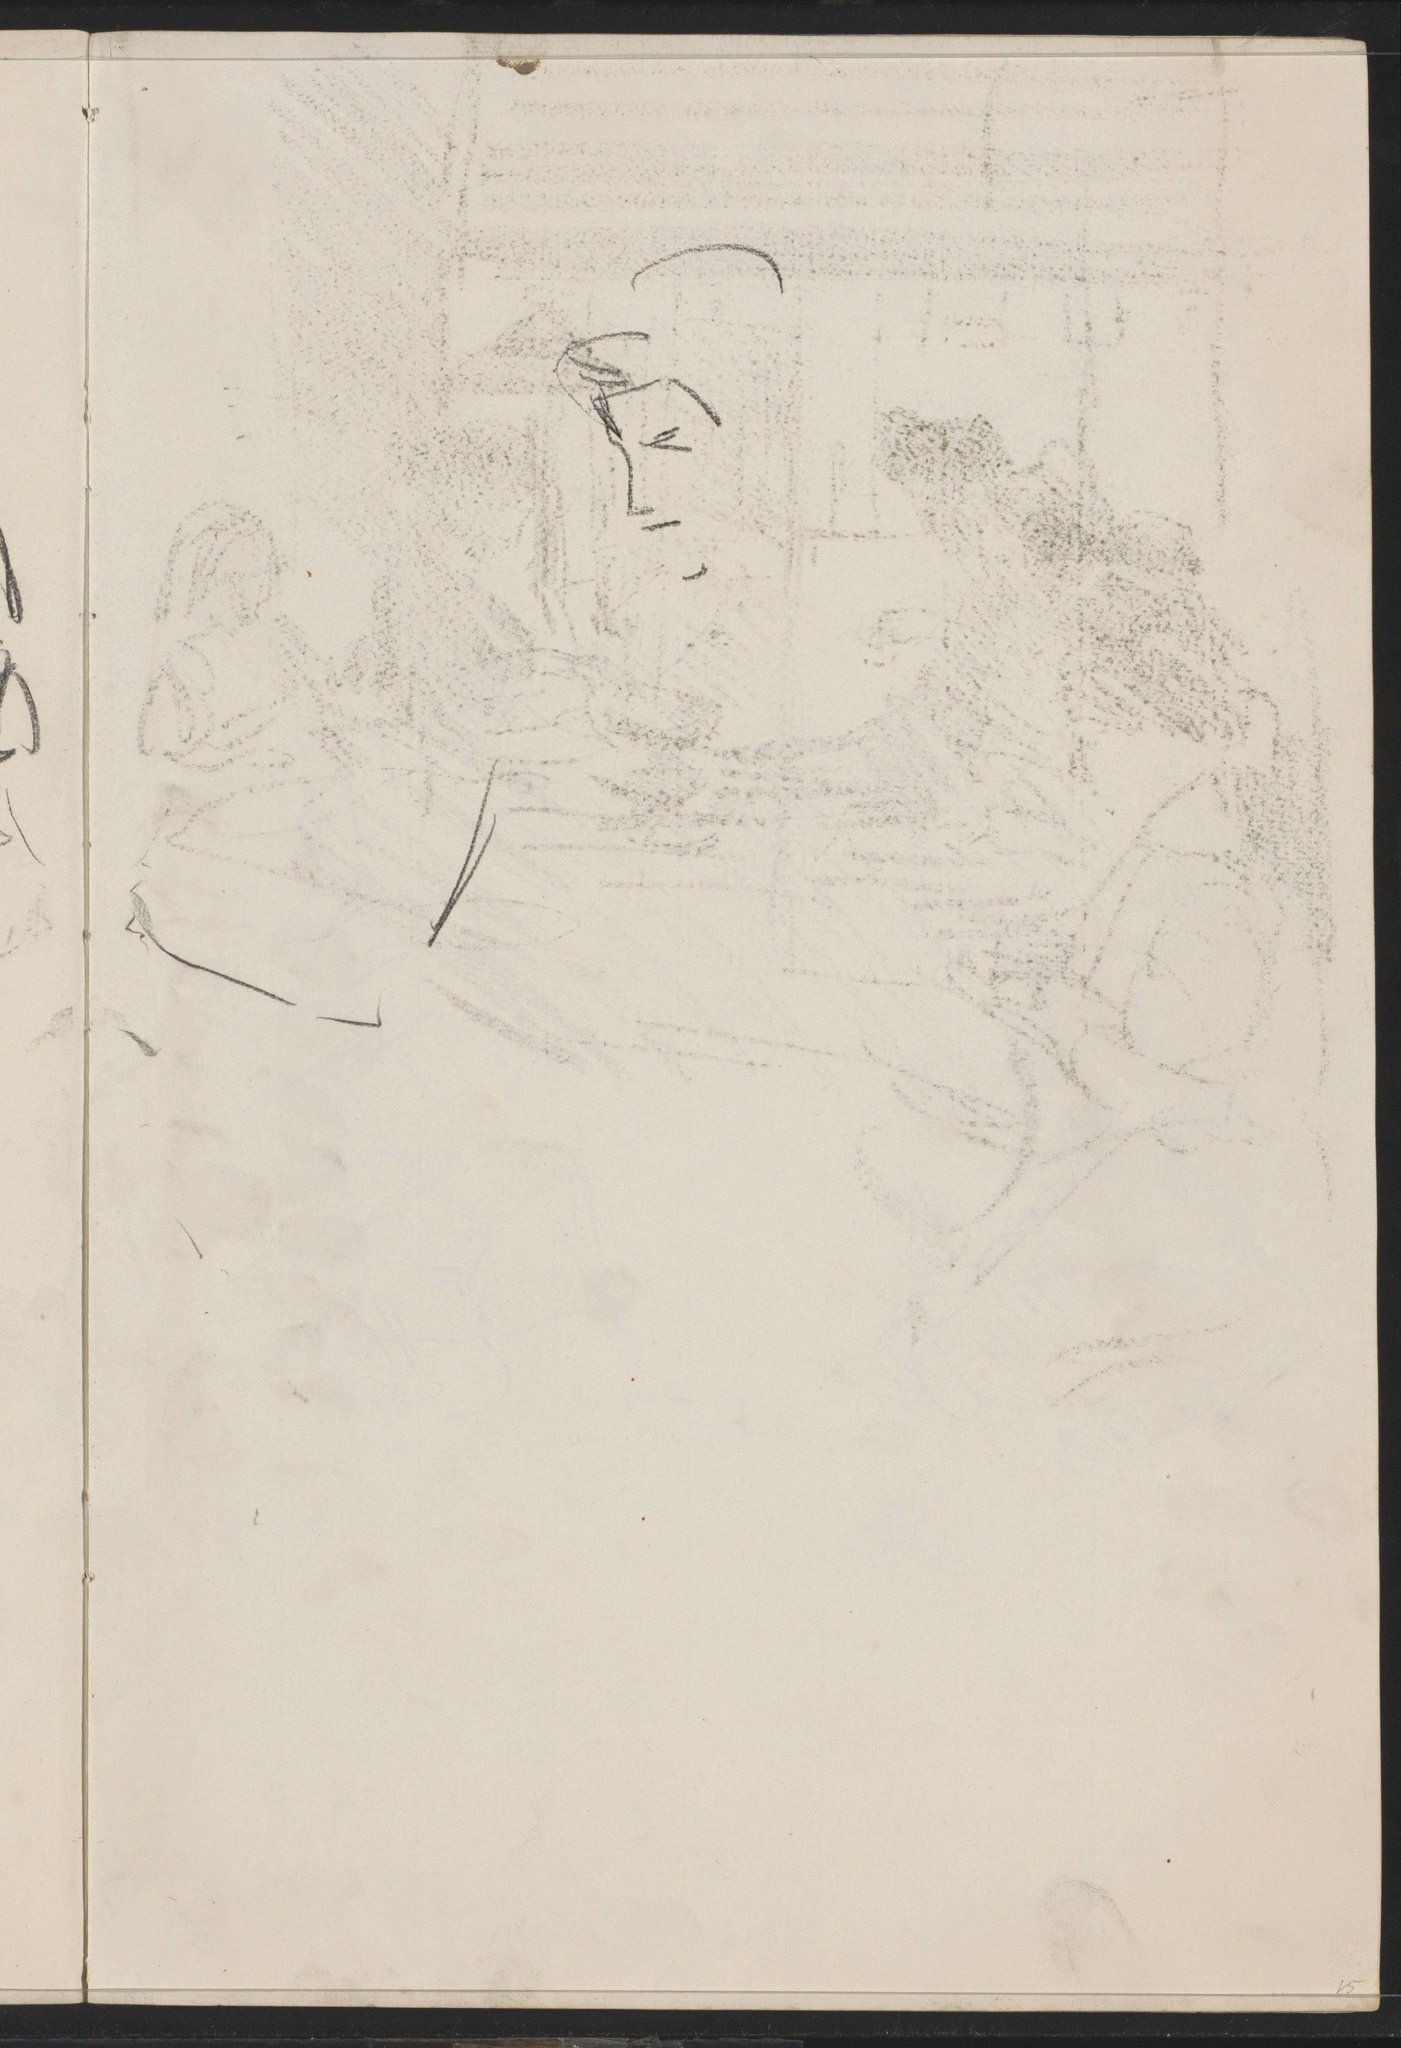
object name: sketchbook leaf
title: Gezicht van een vrouw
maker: isaac israels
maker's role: draughtsman, painter, print maker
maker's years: 1865-1934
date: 1875-1934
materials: chalk, paper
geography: the hague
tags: face, adult woman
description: Blad 15 recto uit schetsboek LXIX met 25 bladen.